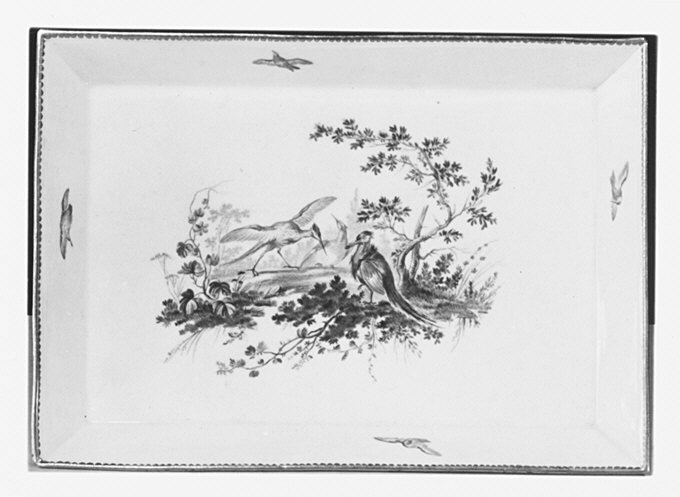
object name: tray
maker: sèvres manufactory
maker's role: manufactory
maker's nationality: french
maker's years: 1740-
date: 1757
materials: soft paste porcelain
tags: birds,trees